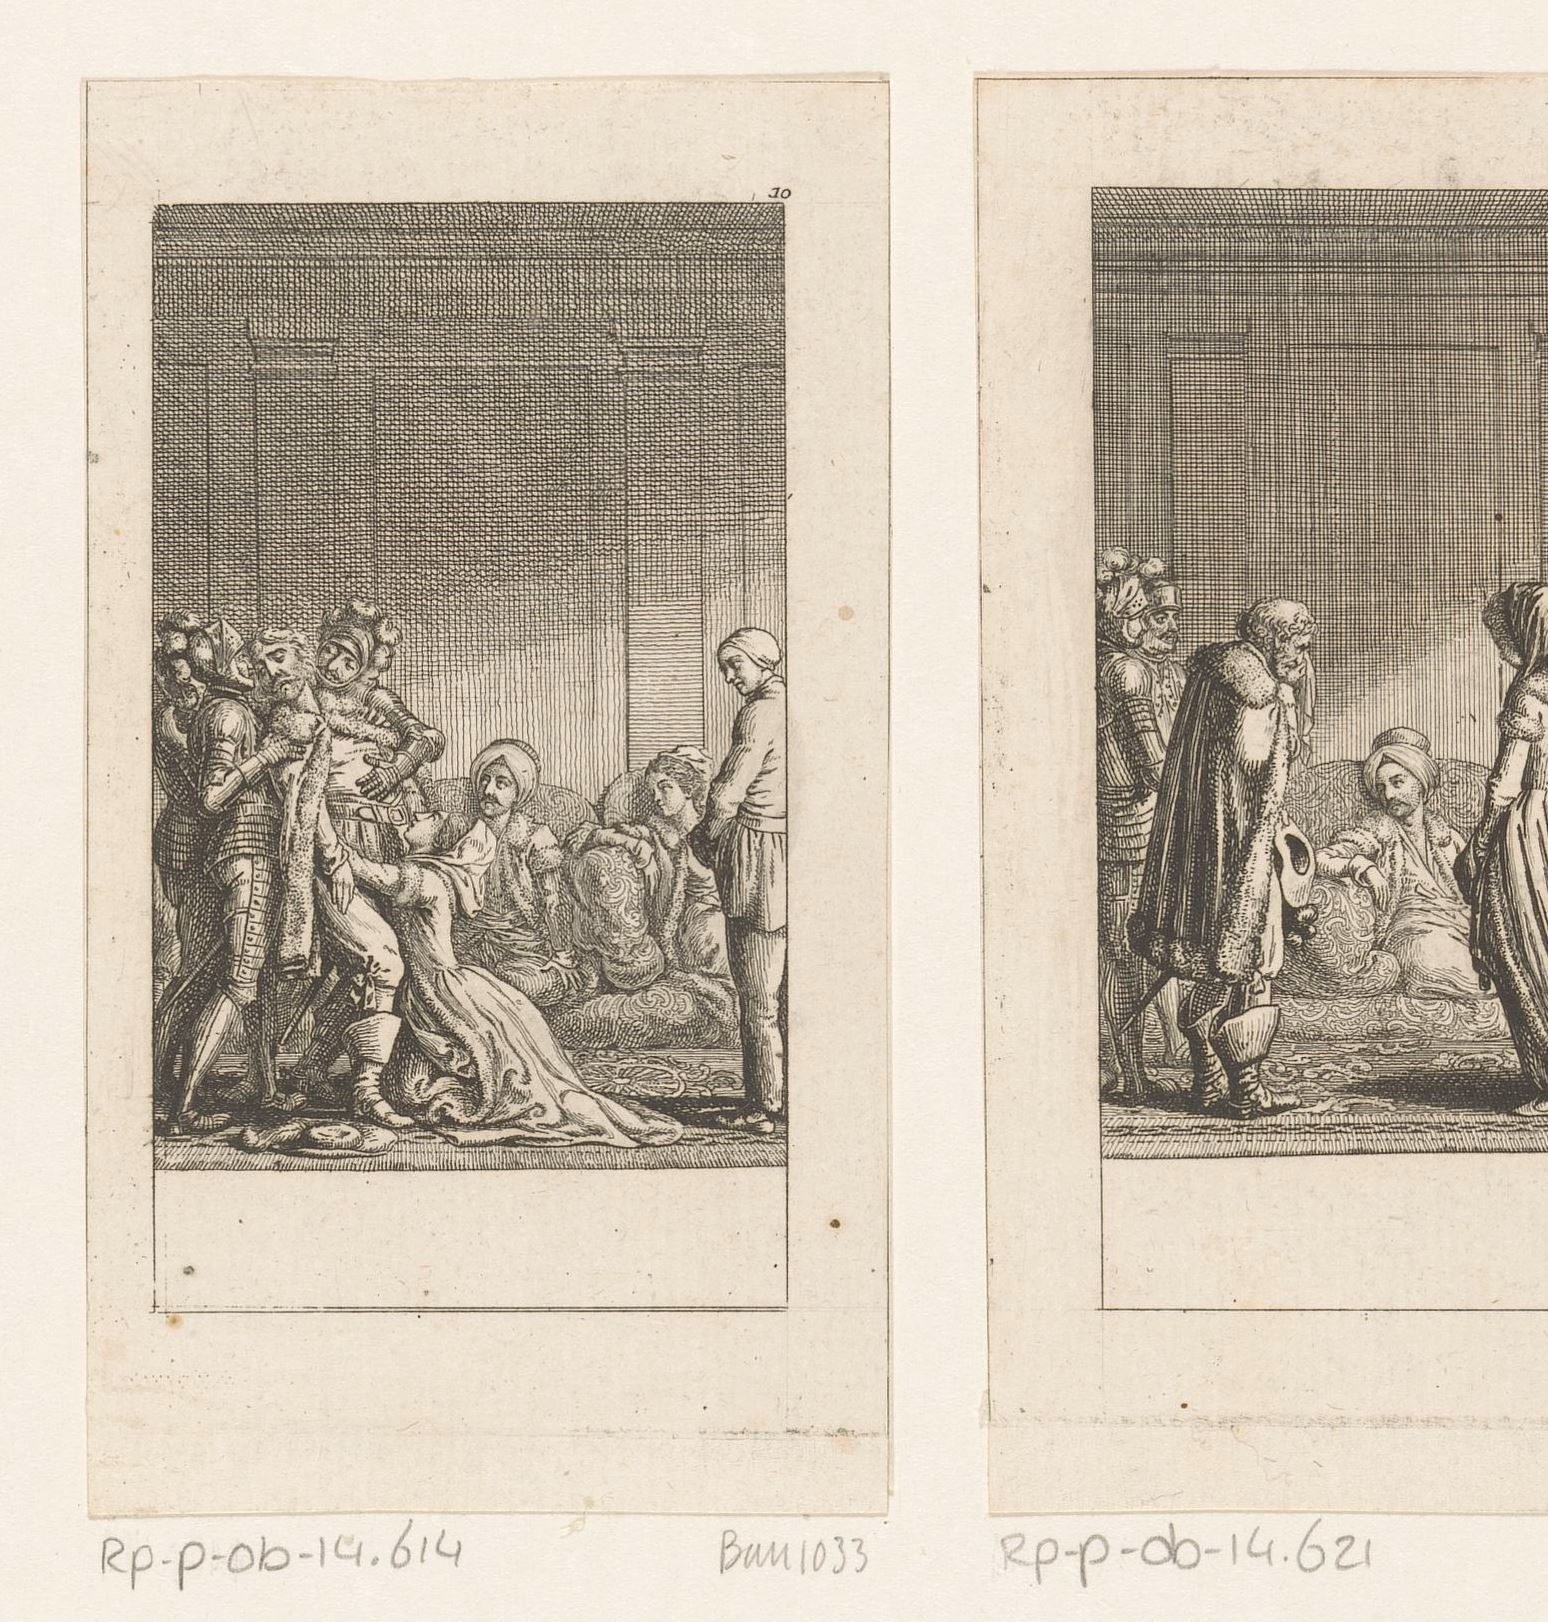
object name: print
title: Adelheid werpt zich aan haar vaders voeten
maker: daniel nikolaus chodowiecki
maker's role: draughtsman, print maker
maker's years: 1726-1801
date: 1783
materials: paper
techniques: etching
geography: berlin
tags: berlin, carrying a person, literature, head-gear: turban, interior of the house, kneeling on both knees - aa - female human figure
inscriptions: collector's mark: Lugt 2228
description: Vervaardigd voor G. F. W. Grossmann's 'Adelheid von Veltheim'. Een latere staat gebruikt in: Königlich Grosbritannischer genealogischer Kalender auf das Jahr 1784. Lauenburg: Berenberg, 1783.